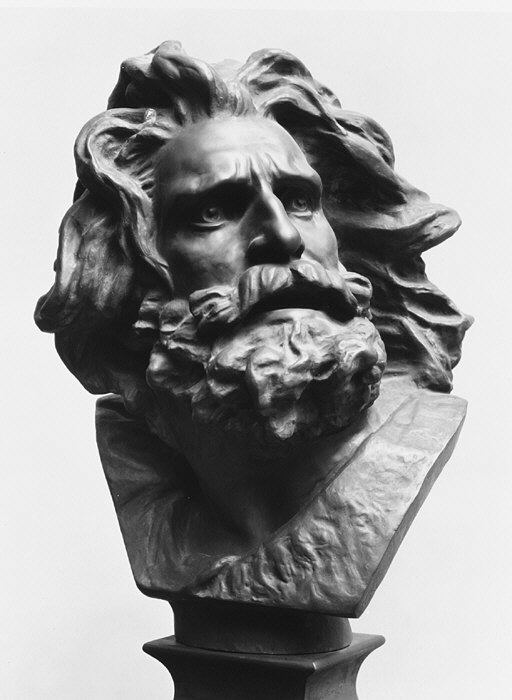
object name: bust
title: Head of the Old Warrior (Tête du Guerrier)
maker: françois rude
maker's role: artist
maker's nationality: french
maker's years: 1784-1855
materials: bronze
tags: men